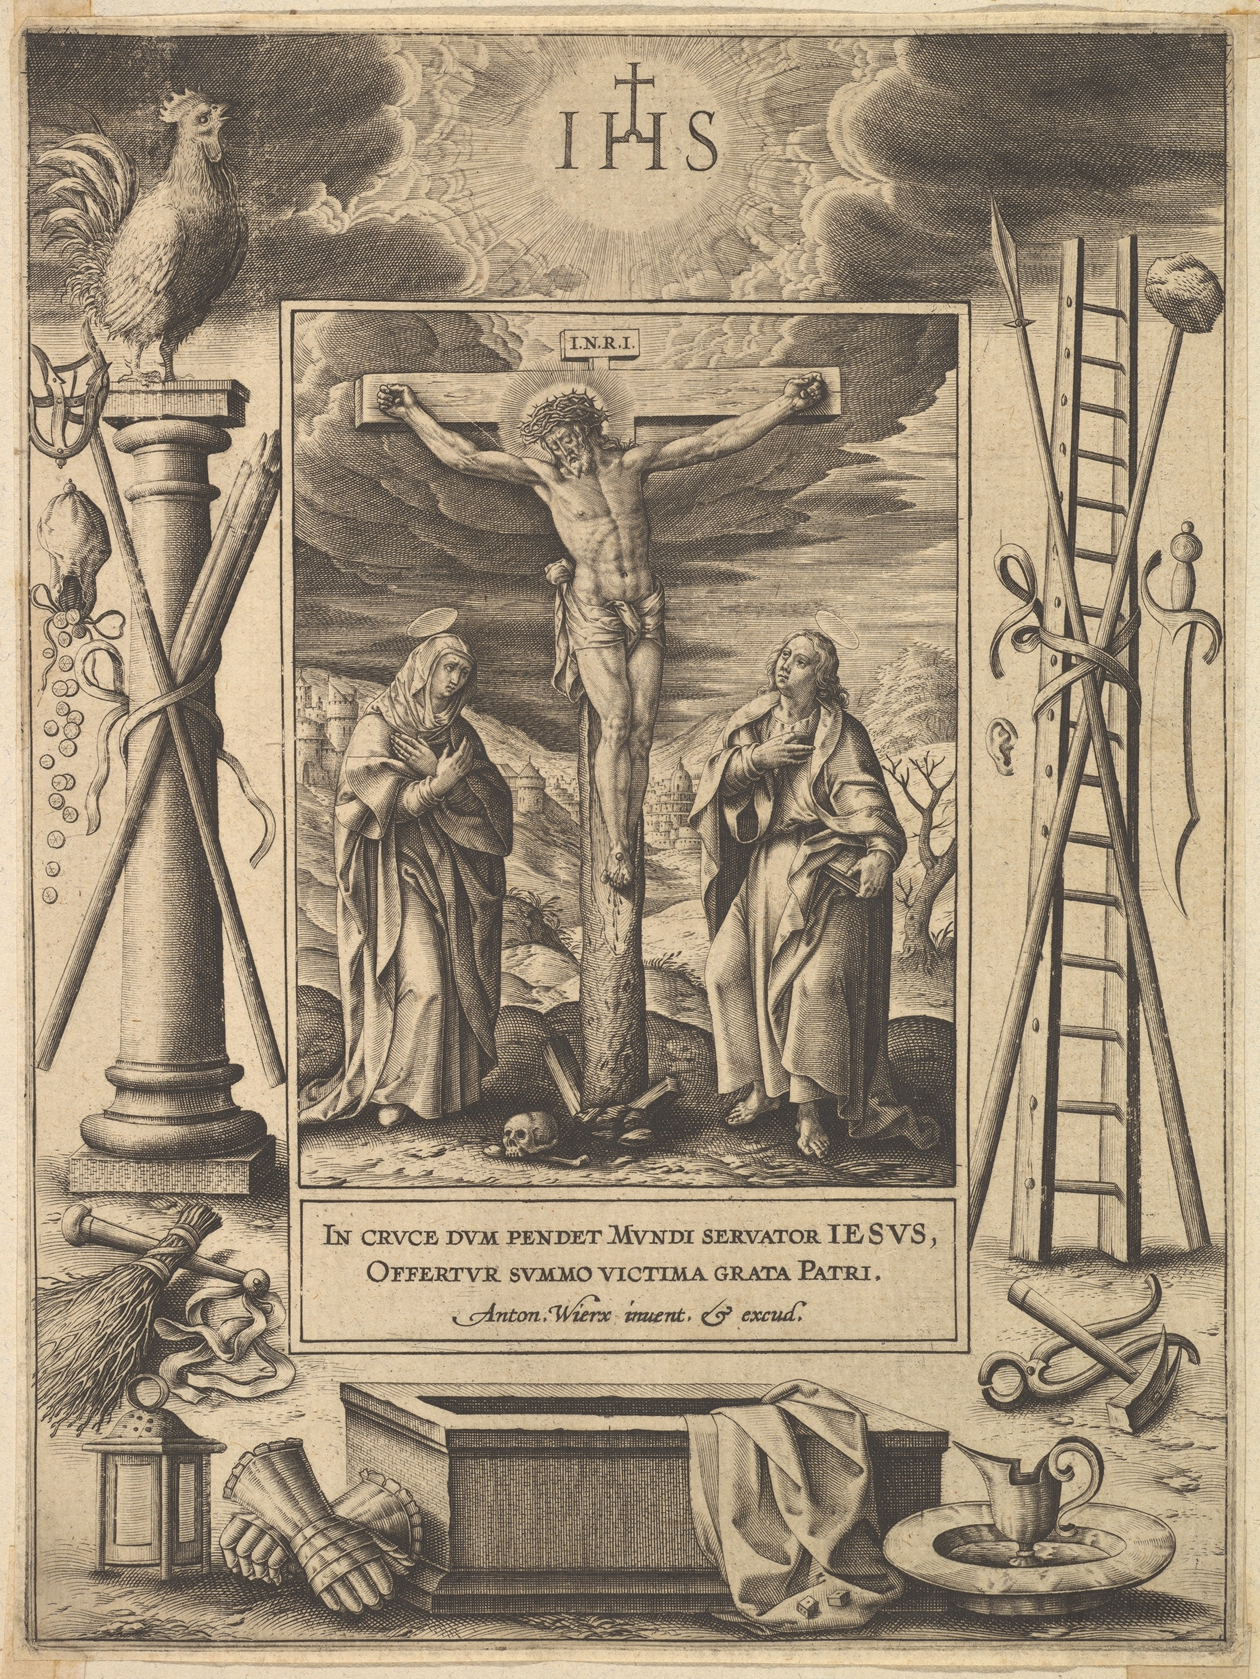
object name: print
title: Christ on the Cross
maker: antonius wierix, ii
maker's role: artist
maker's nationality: netherlandish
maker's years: 1555-1604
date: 1604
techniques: engraving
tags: roosters,christ,virgin mary,crucifixion,ladders